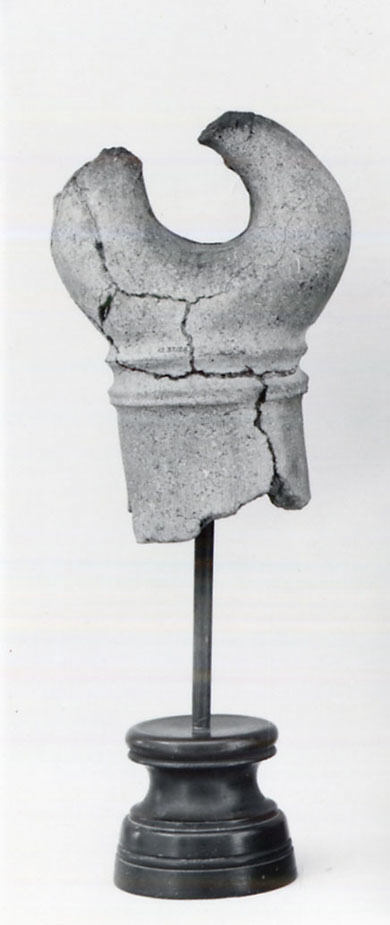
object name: haniwa fragment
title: Haniwa Column Fragment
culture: japanese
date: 601-700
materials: clay